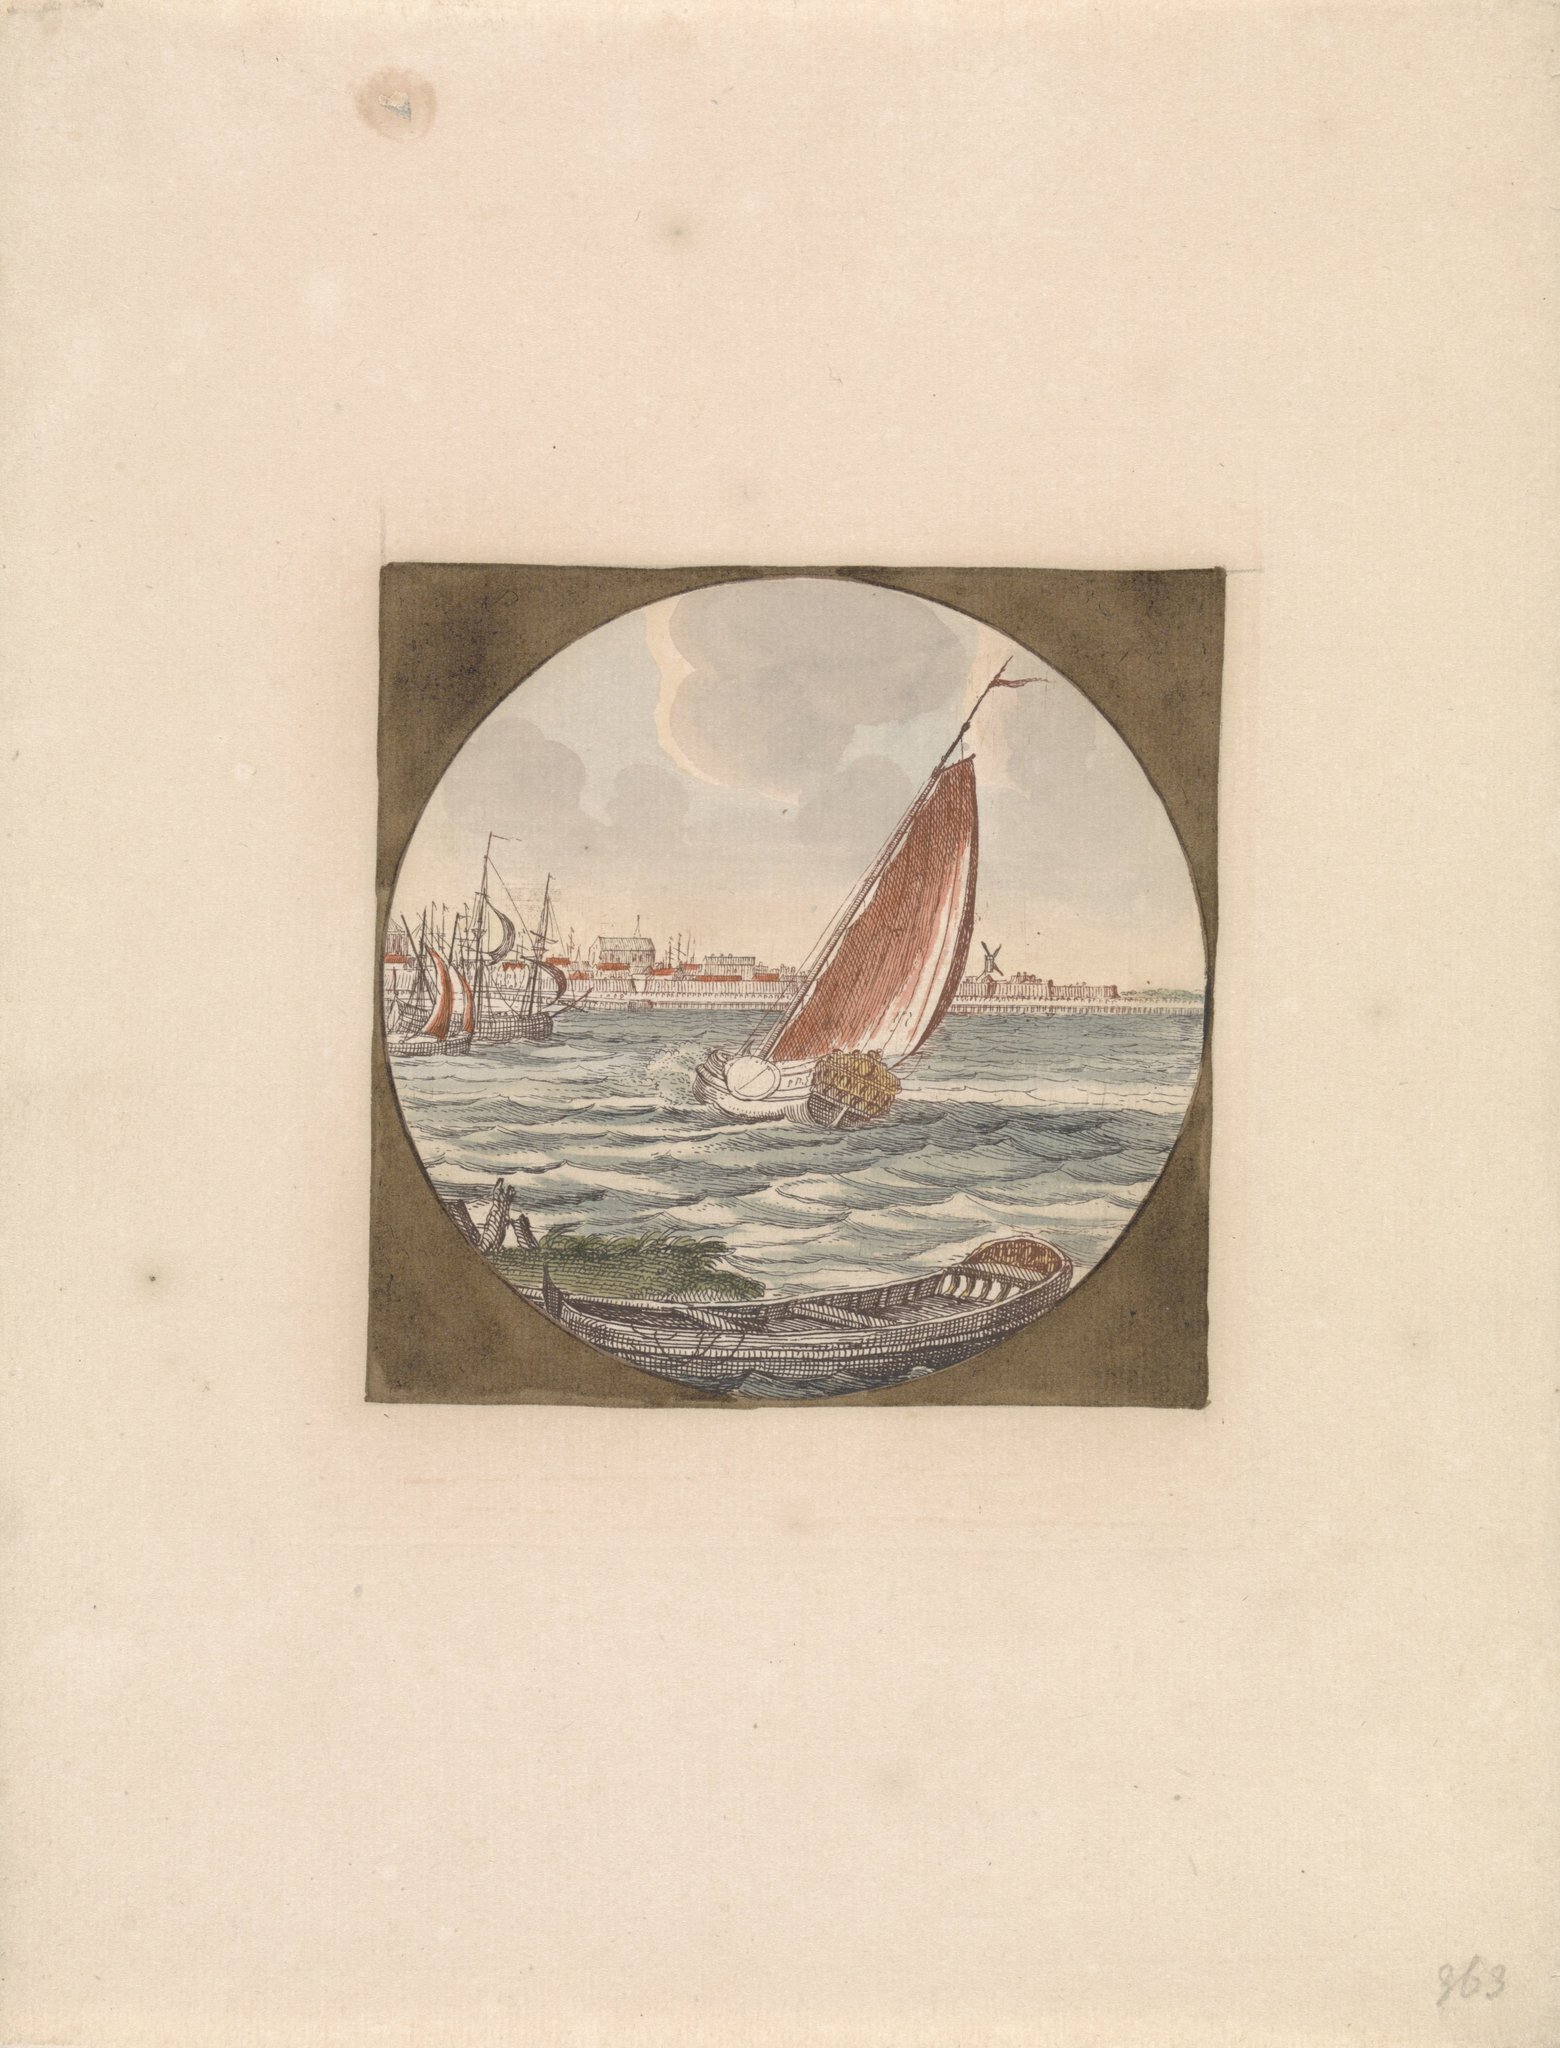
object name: print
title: Schepen op zee (serie B)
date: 1688-1750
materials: paper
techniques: etching, hand coloring, lithography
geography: netherlands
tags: sailing-ship, sailing-boat, sea (seascape)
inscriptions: collector's mark: Lugt 2228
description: Een varend zeilschip gezien op de spiegel. Op de voorgrond een aangemeerde sloep. Aan de horizon een stad.